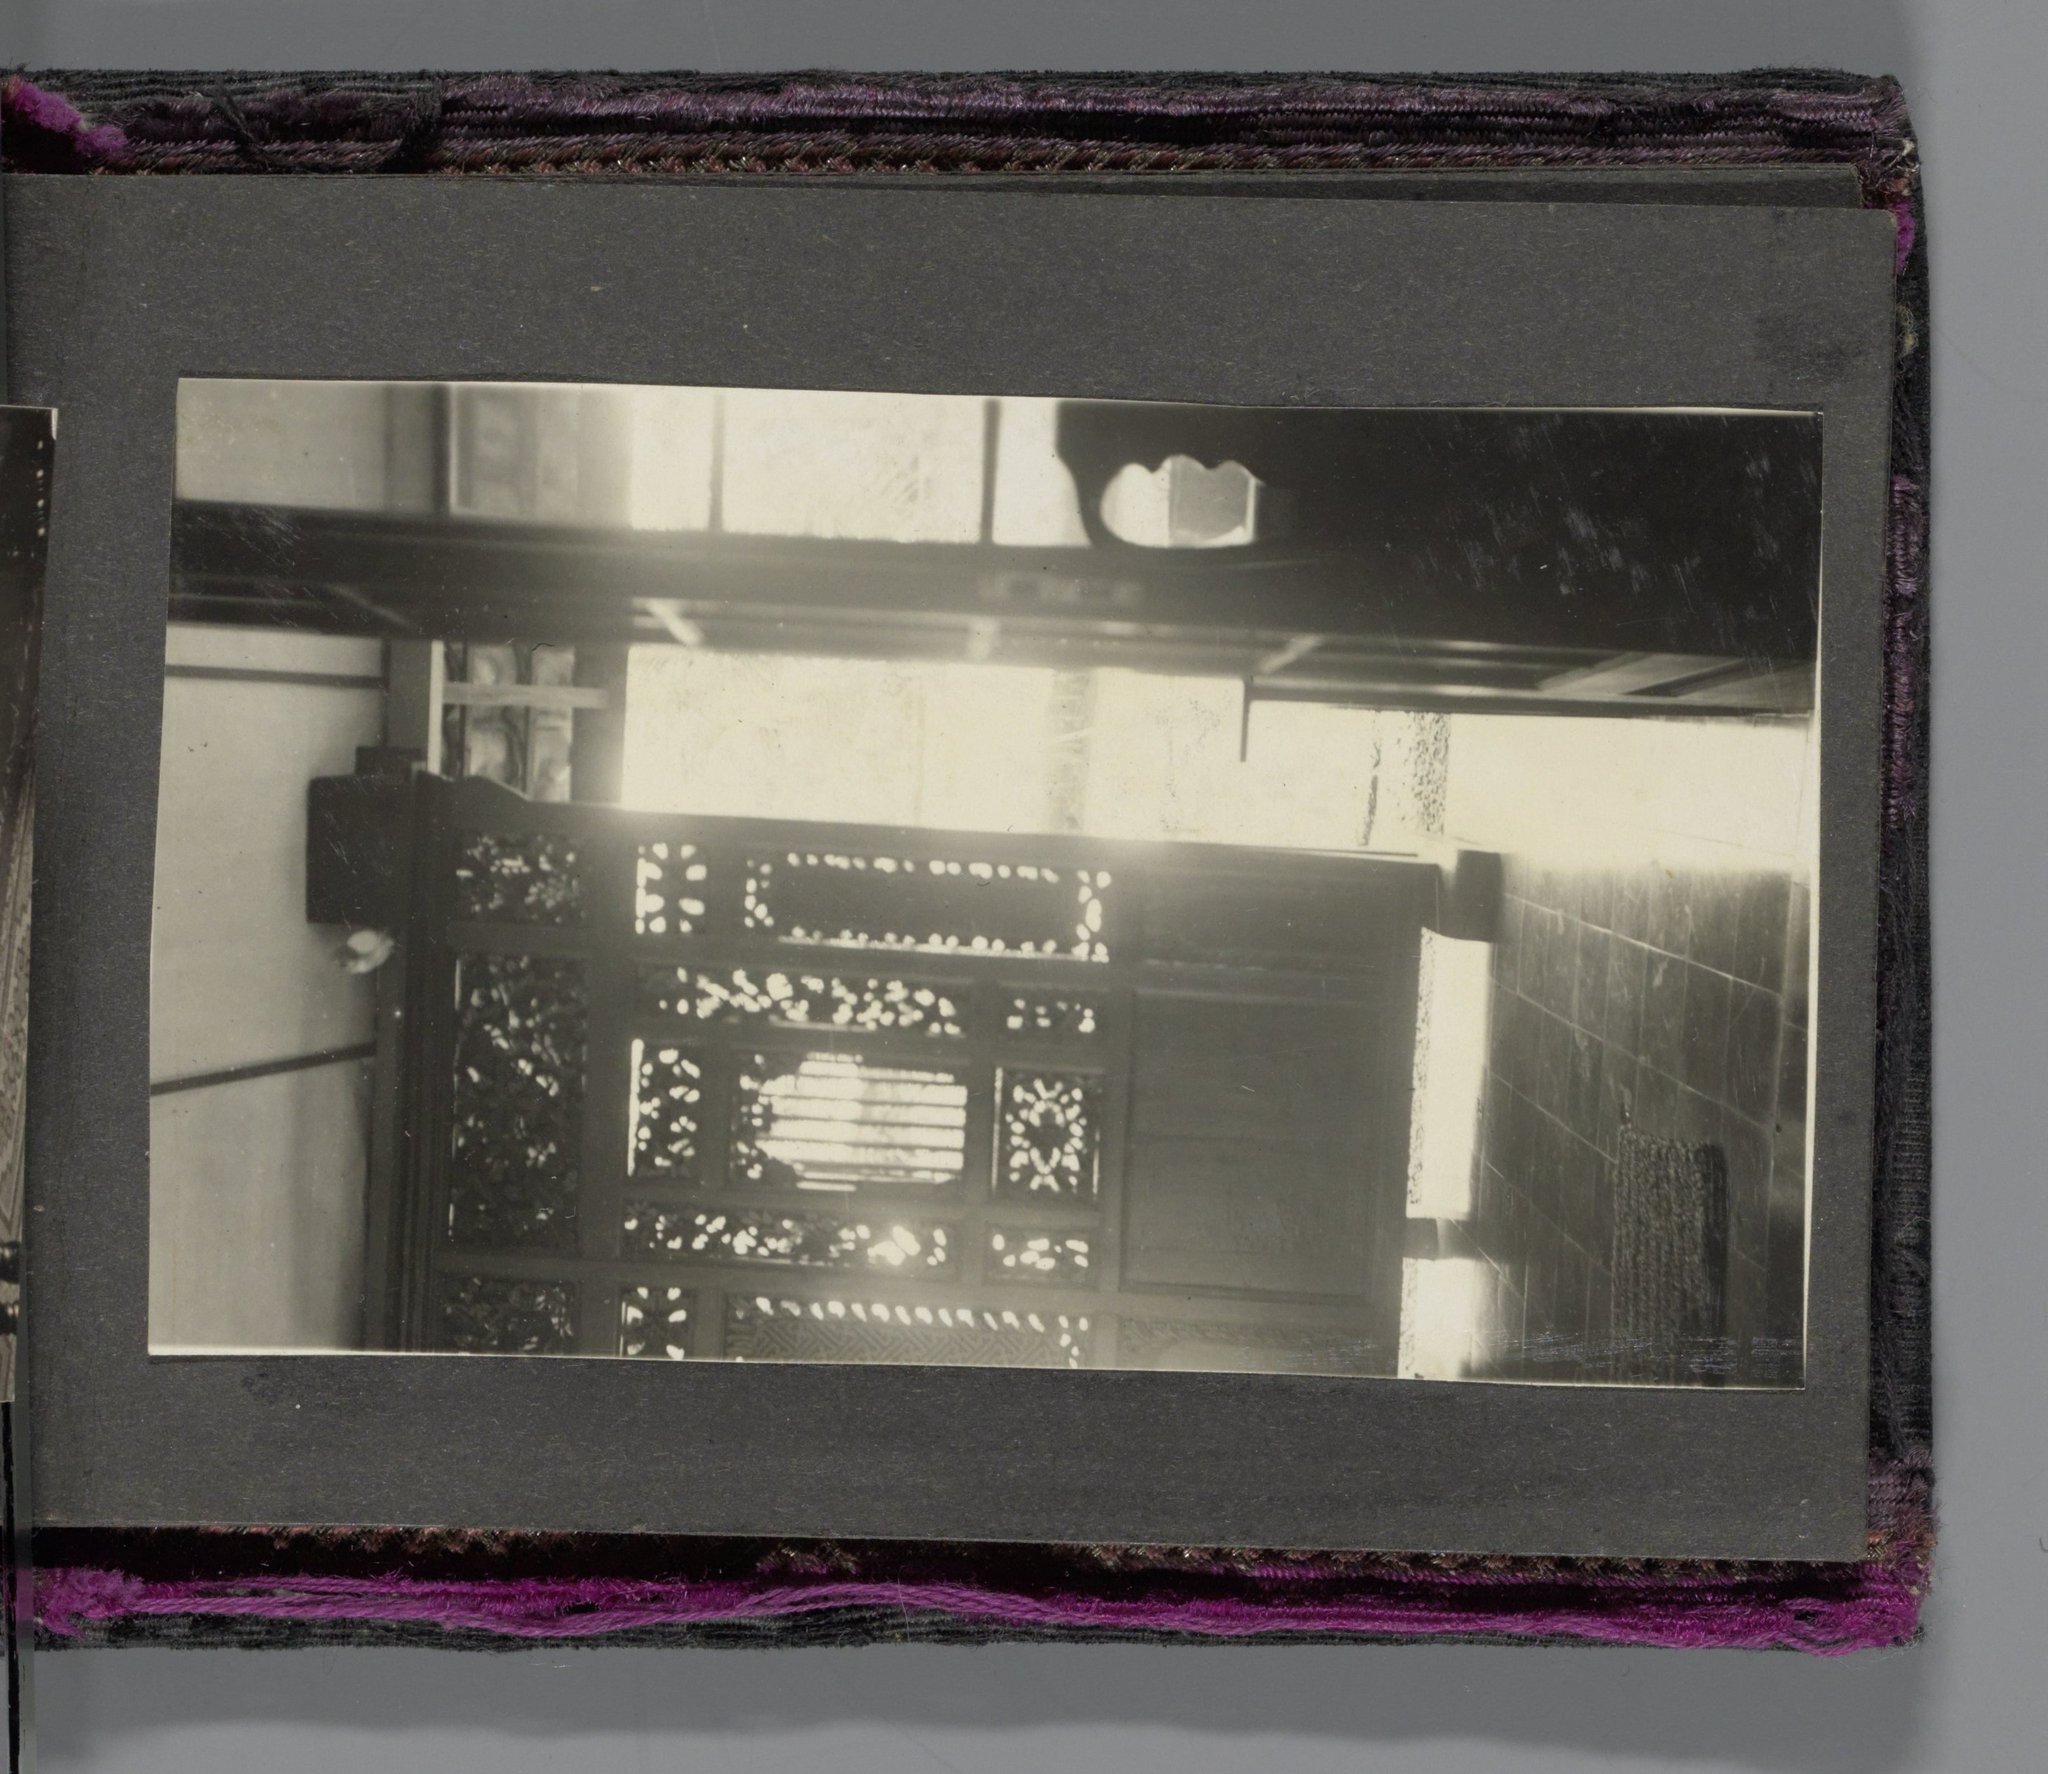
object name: photograph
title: Paneel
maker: elsa silberstein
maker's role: amateurfotograaf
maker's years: -2006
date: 1935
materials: photographic support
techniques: gelatin silver print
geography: bandung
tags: amsterdam, elsa silberstein, interior of the house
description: Een paneel van houtsnijwerk hangend aan de wand. In het woonhuis van Elsa Silberstein en haar man, thesaurier-generaal in Bandung in 1935. Schilderijtjes aan de muur. Onderdeel van het fotoalbum met zwart-wit foto's van het interieur van het huis van de familie Silberstein in Bandung in Nederlands-Indië.